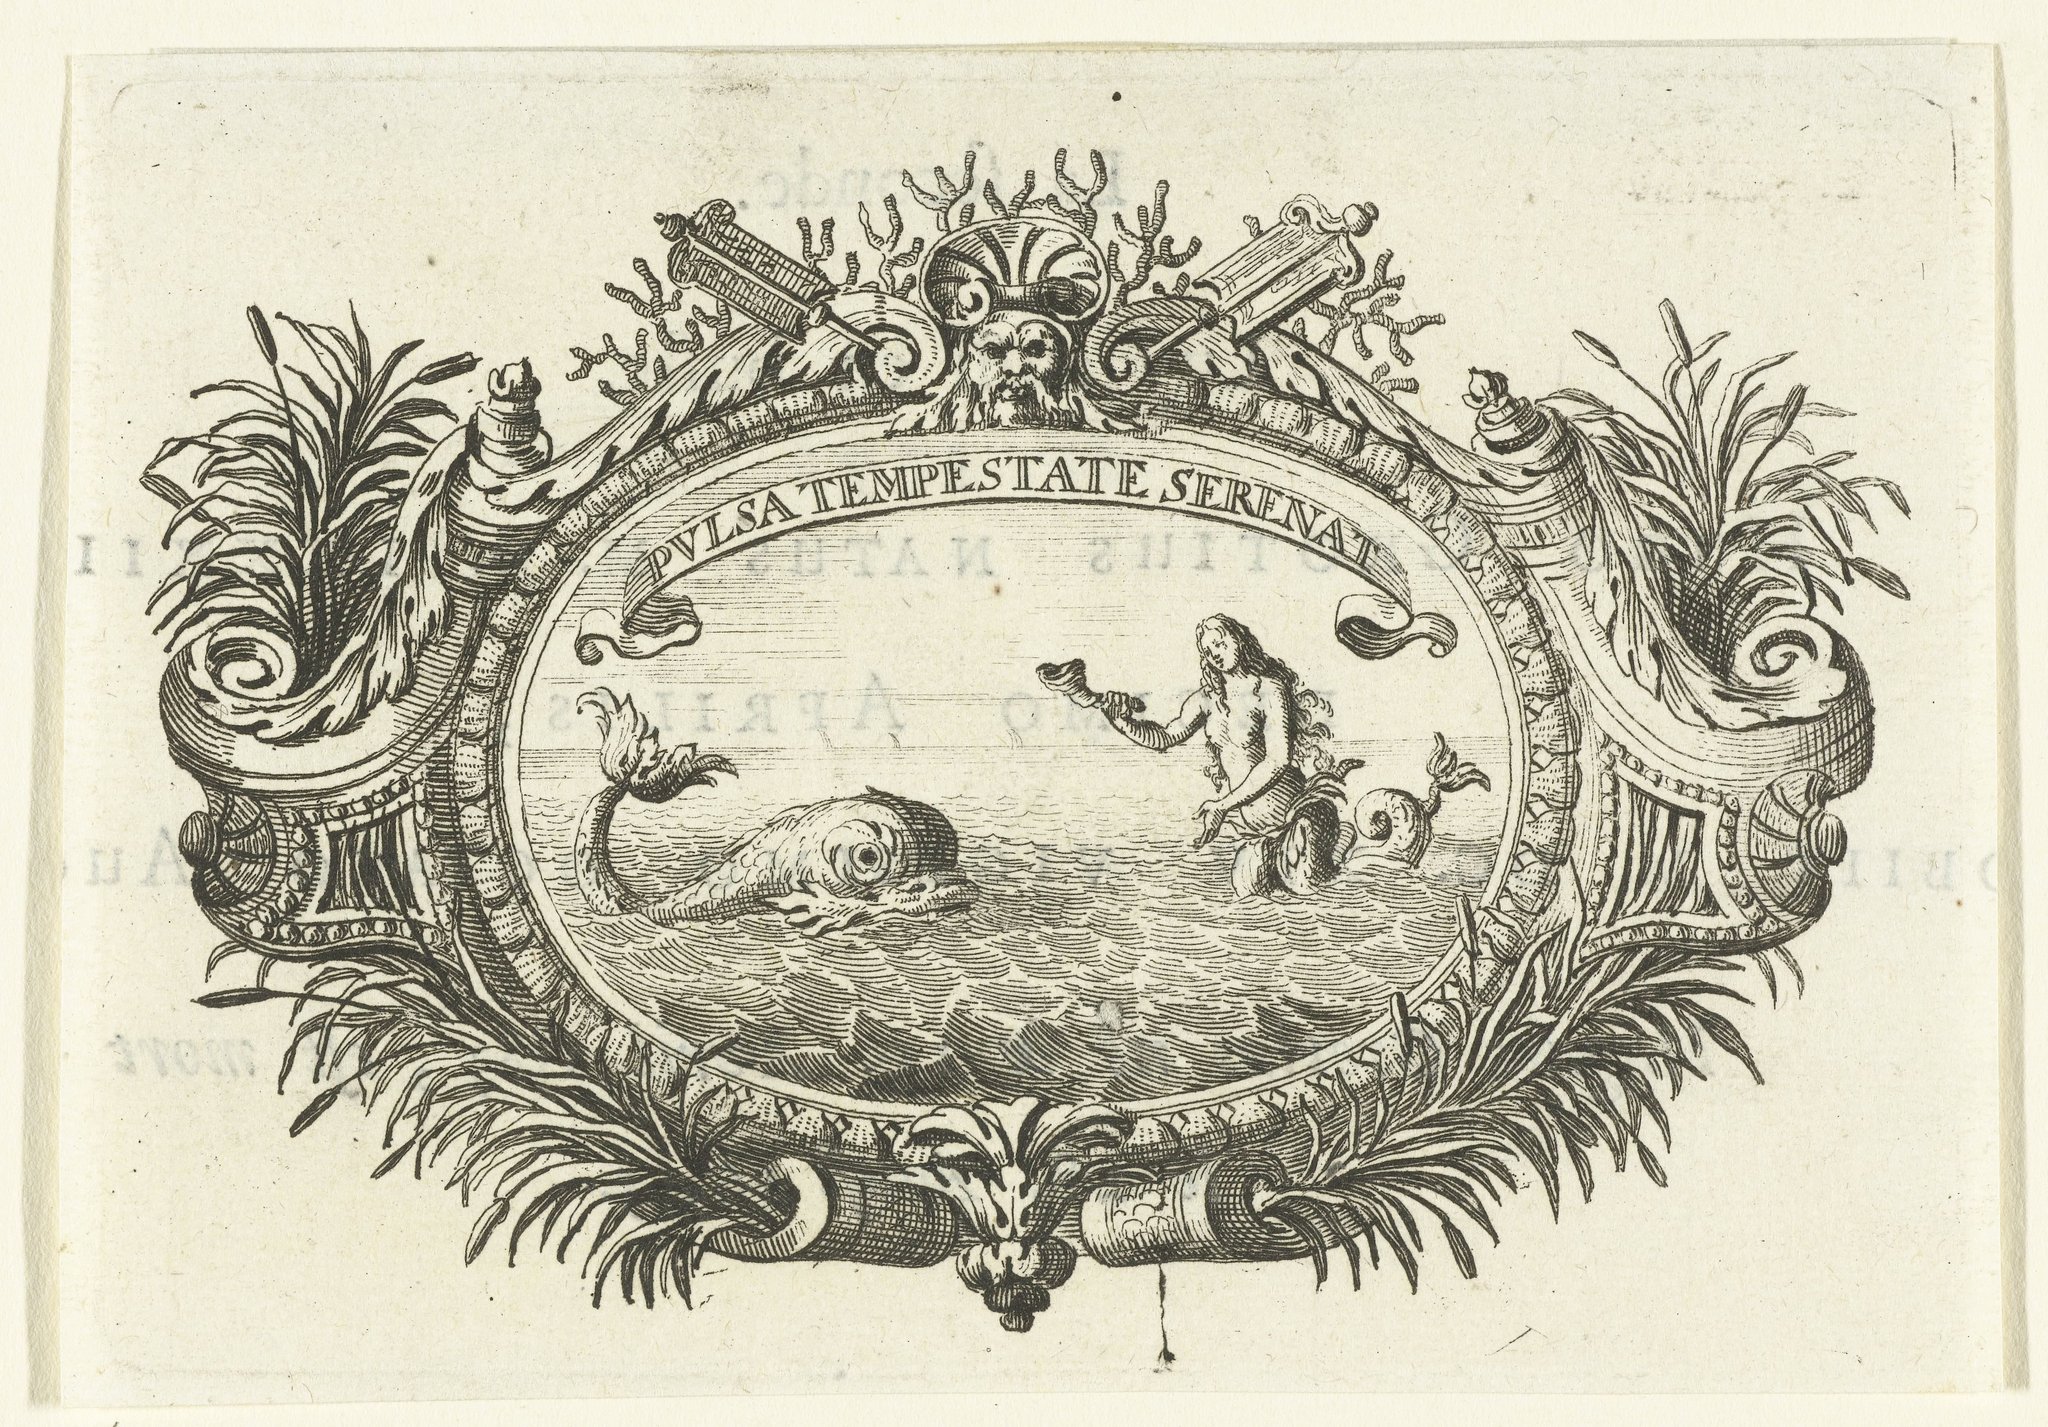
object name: ornament print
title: Histoire metallique de la république de Hollande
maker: Anonymous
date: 1688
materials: paper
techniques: etching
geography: amsterdam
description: De rand van de cartouche is versierd met lisdoddenen. Uit serie vignetten met zeegoden en allegorieën, als illustratie gebruikt in het boek Histoire metallique de la république de Hollande van P. Bizot.